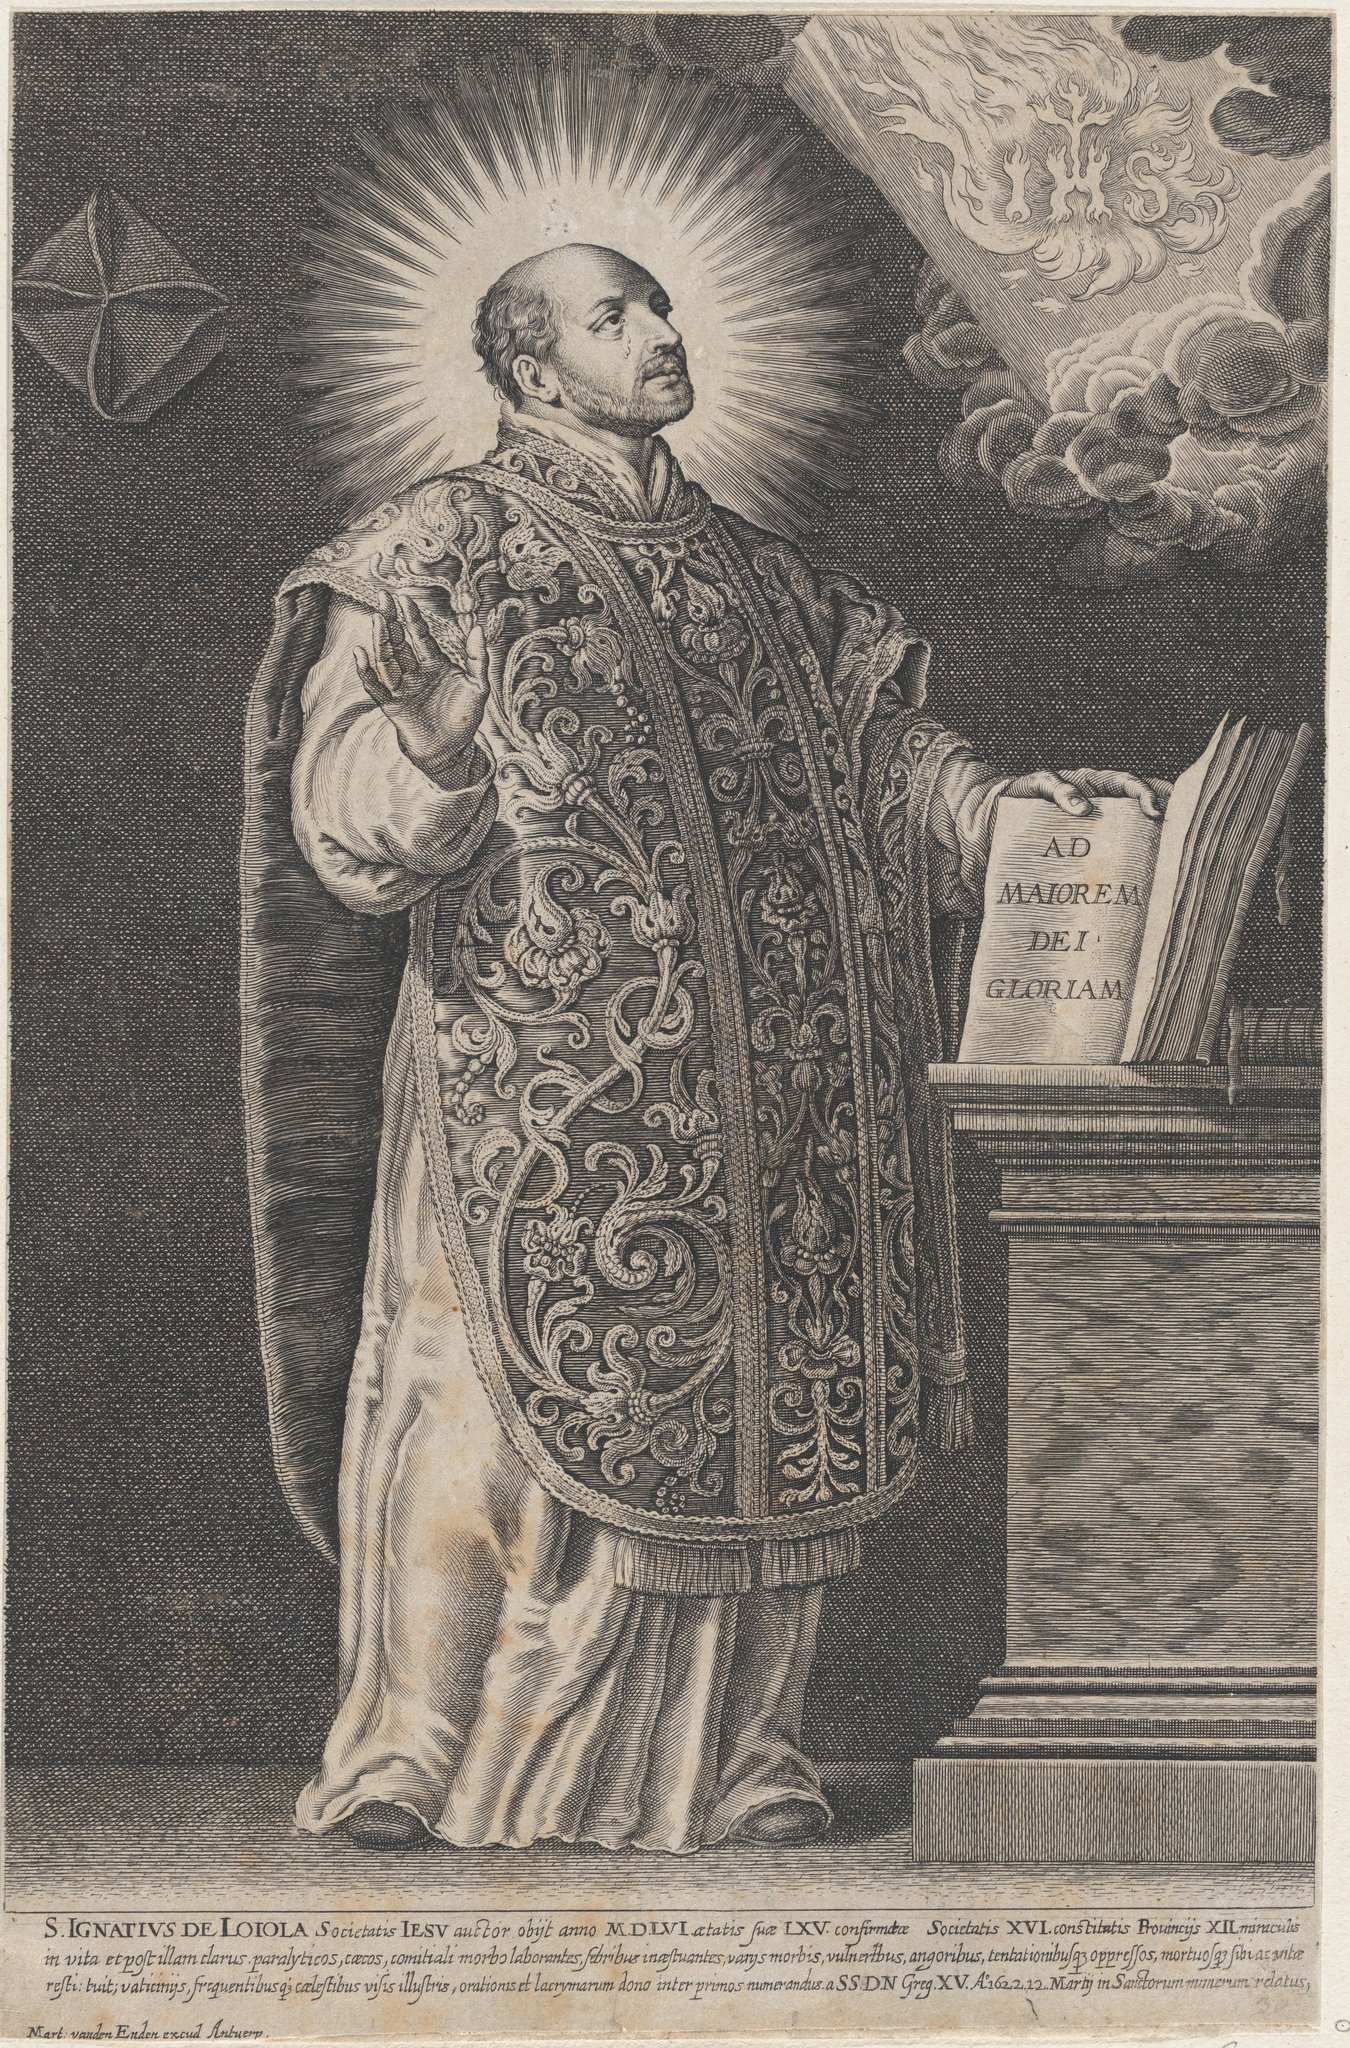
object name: print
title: Saint Ignatius Loyola, standing and holding an open book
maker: Anonymous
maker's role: artist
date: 1630-1654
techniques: engraving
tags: books,men,saints